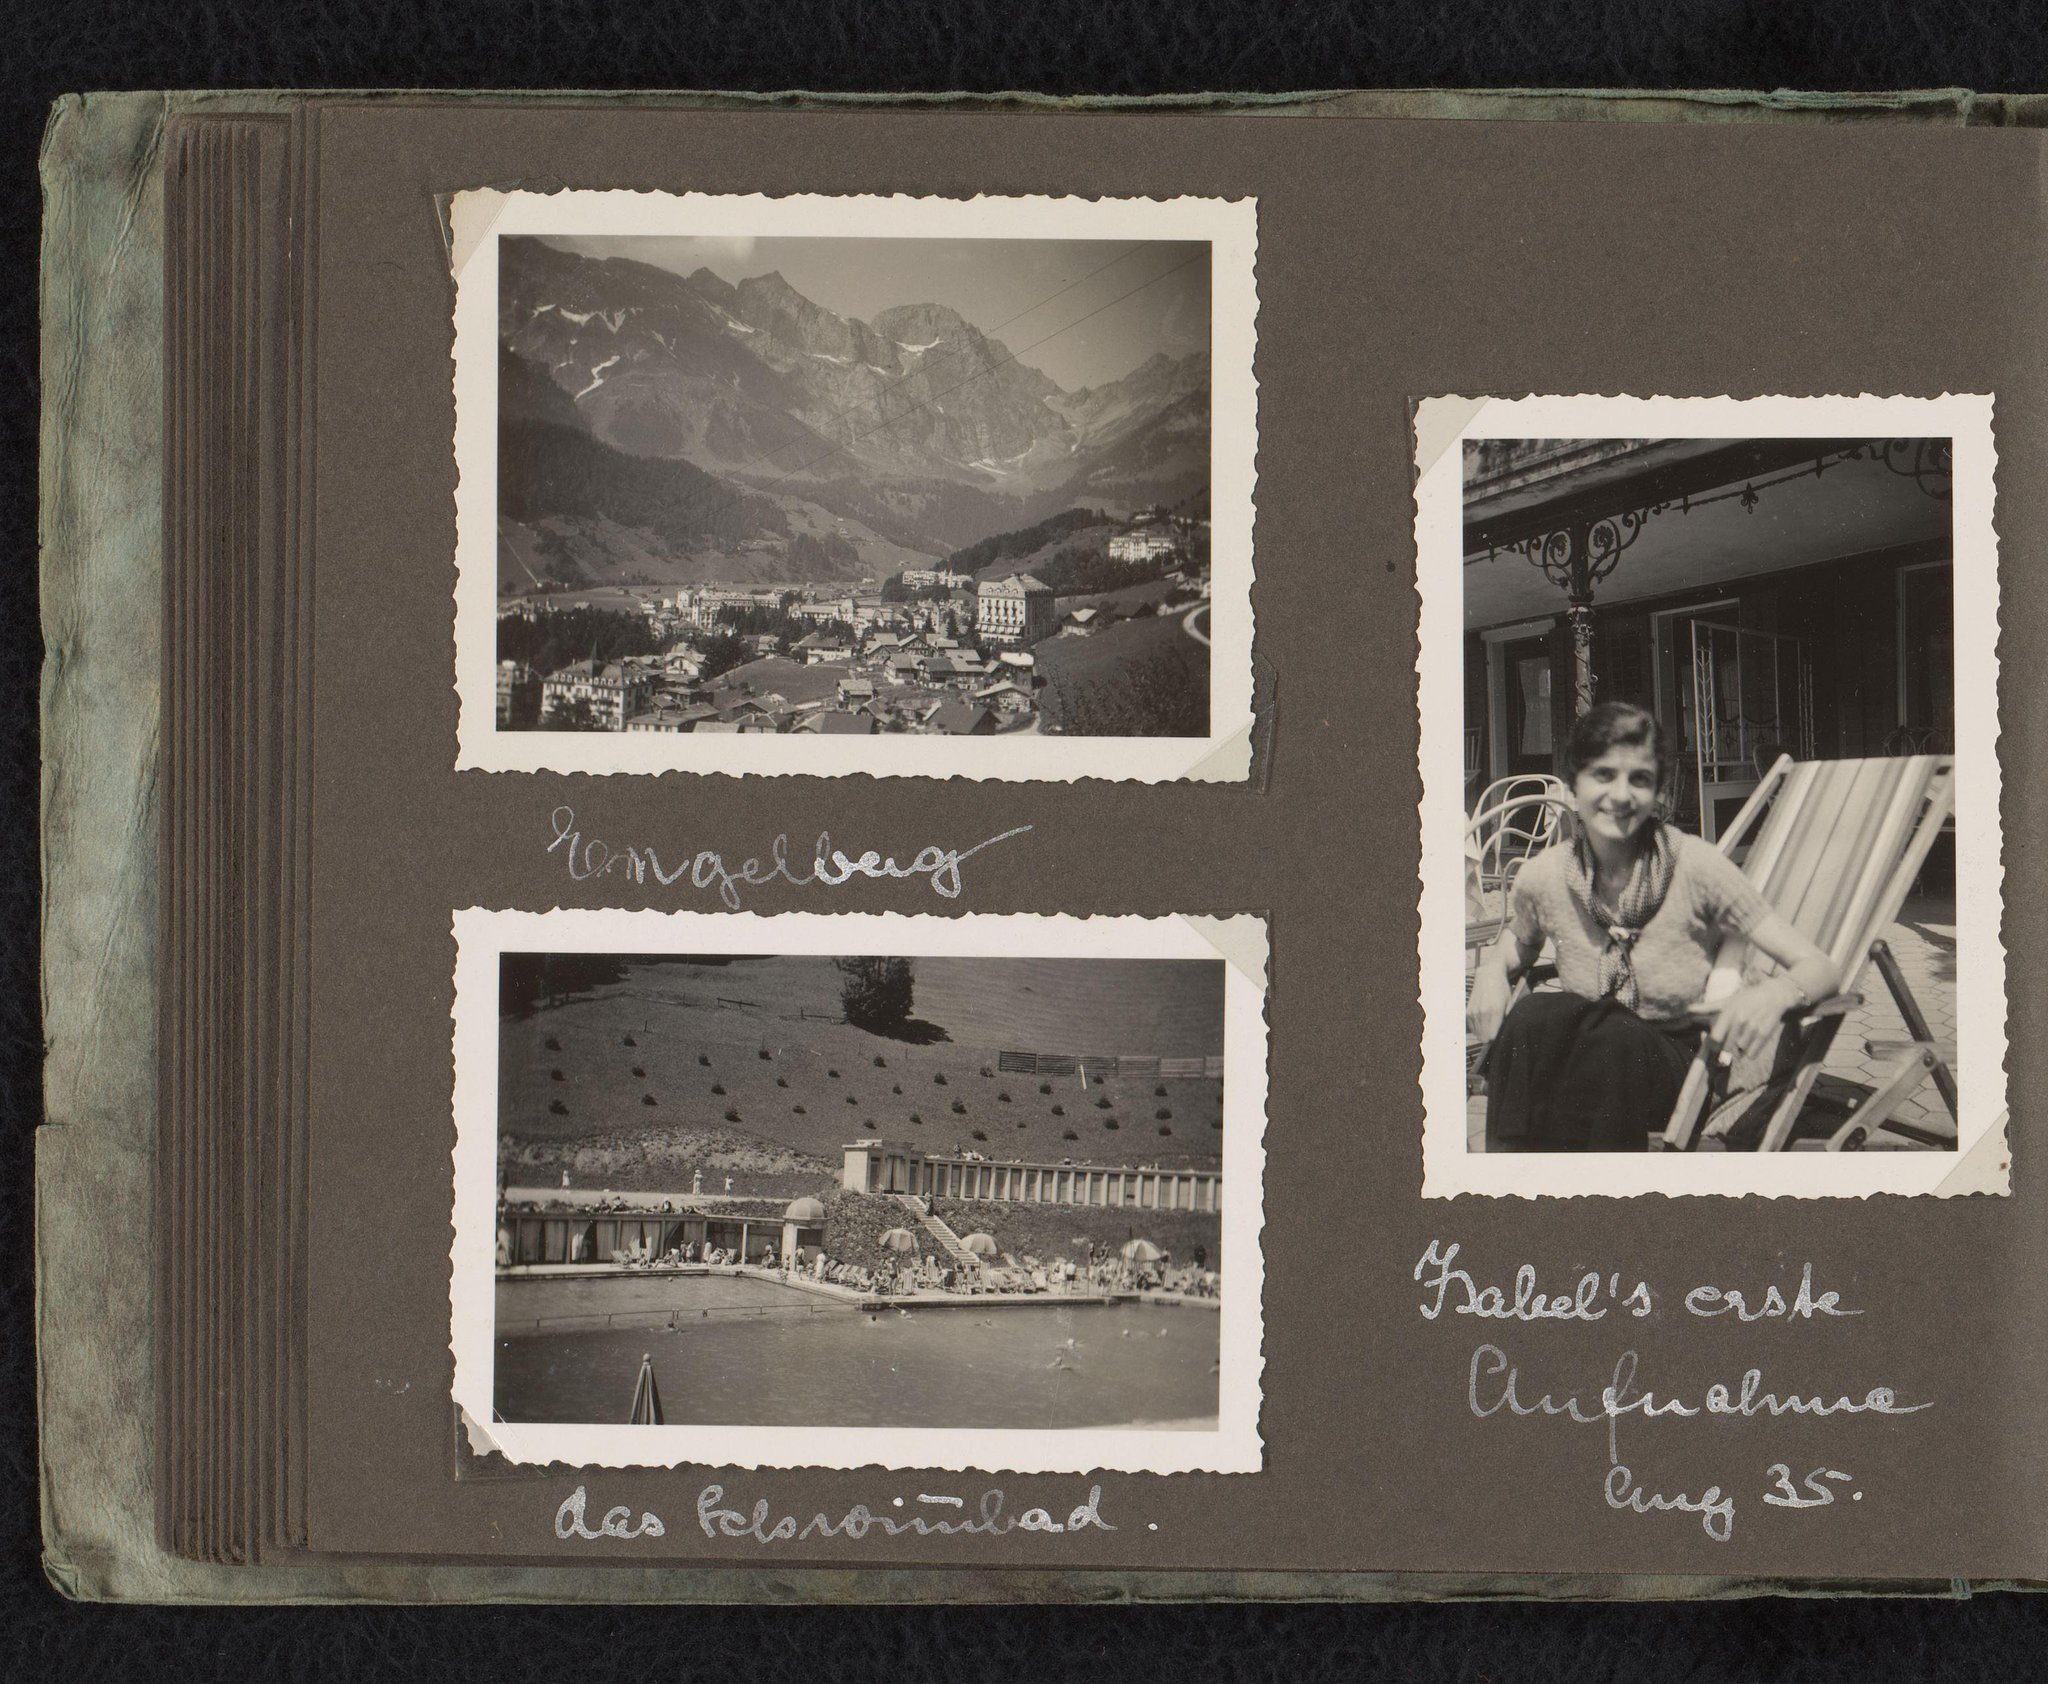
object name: photograph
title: De eerste foto genomen door Isabel Wachenheimer van haar kindermeisje, Engelberg en het zwembad te Schwerin, augustus 1935, Engelberg (Zwitserland)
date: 1908-1935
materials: paper, photographic support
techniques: gelatin silver print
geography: switzerland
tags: the family travelling, on holiday, swimming (sport)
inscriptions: inscription: ‘Engelberg Isabel's erste Aufnahme Aug 35. das ?’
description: Blad bevat drie foto's. Portret van het kindermeisje van de familie Wachenheimer door Isabel, gezicht op Engelberg en op het zwembad te Schwerin. Uit het album, half formaat, groen geaderd kartonomslag met koordbinding.